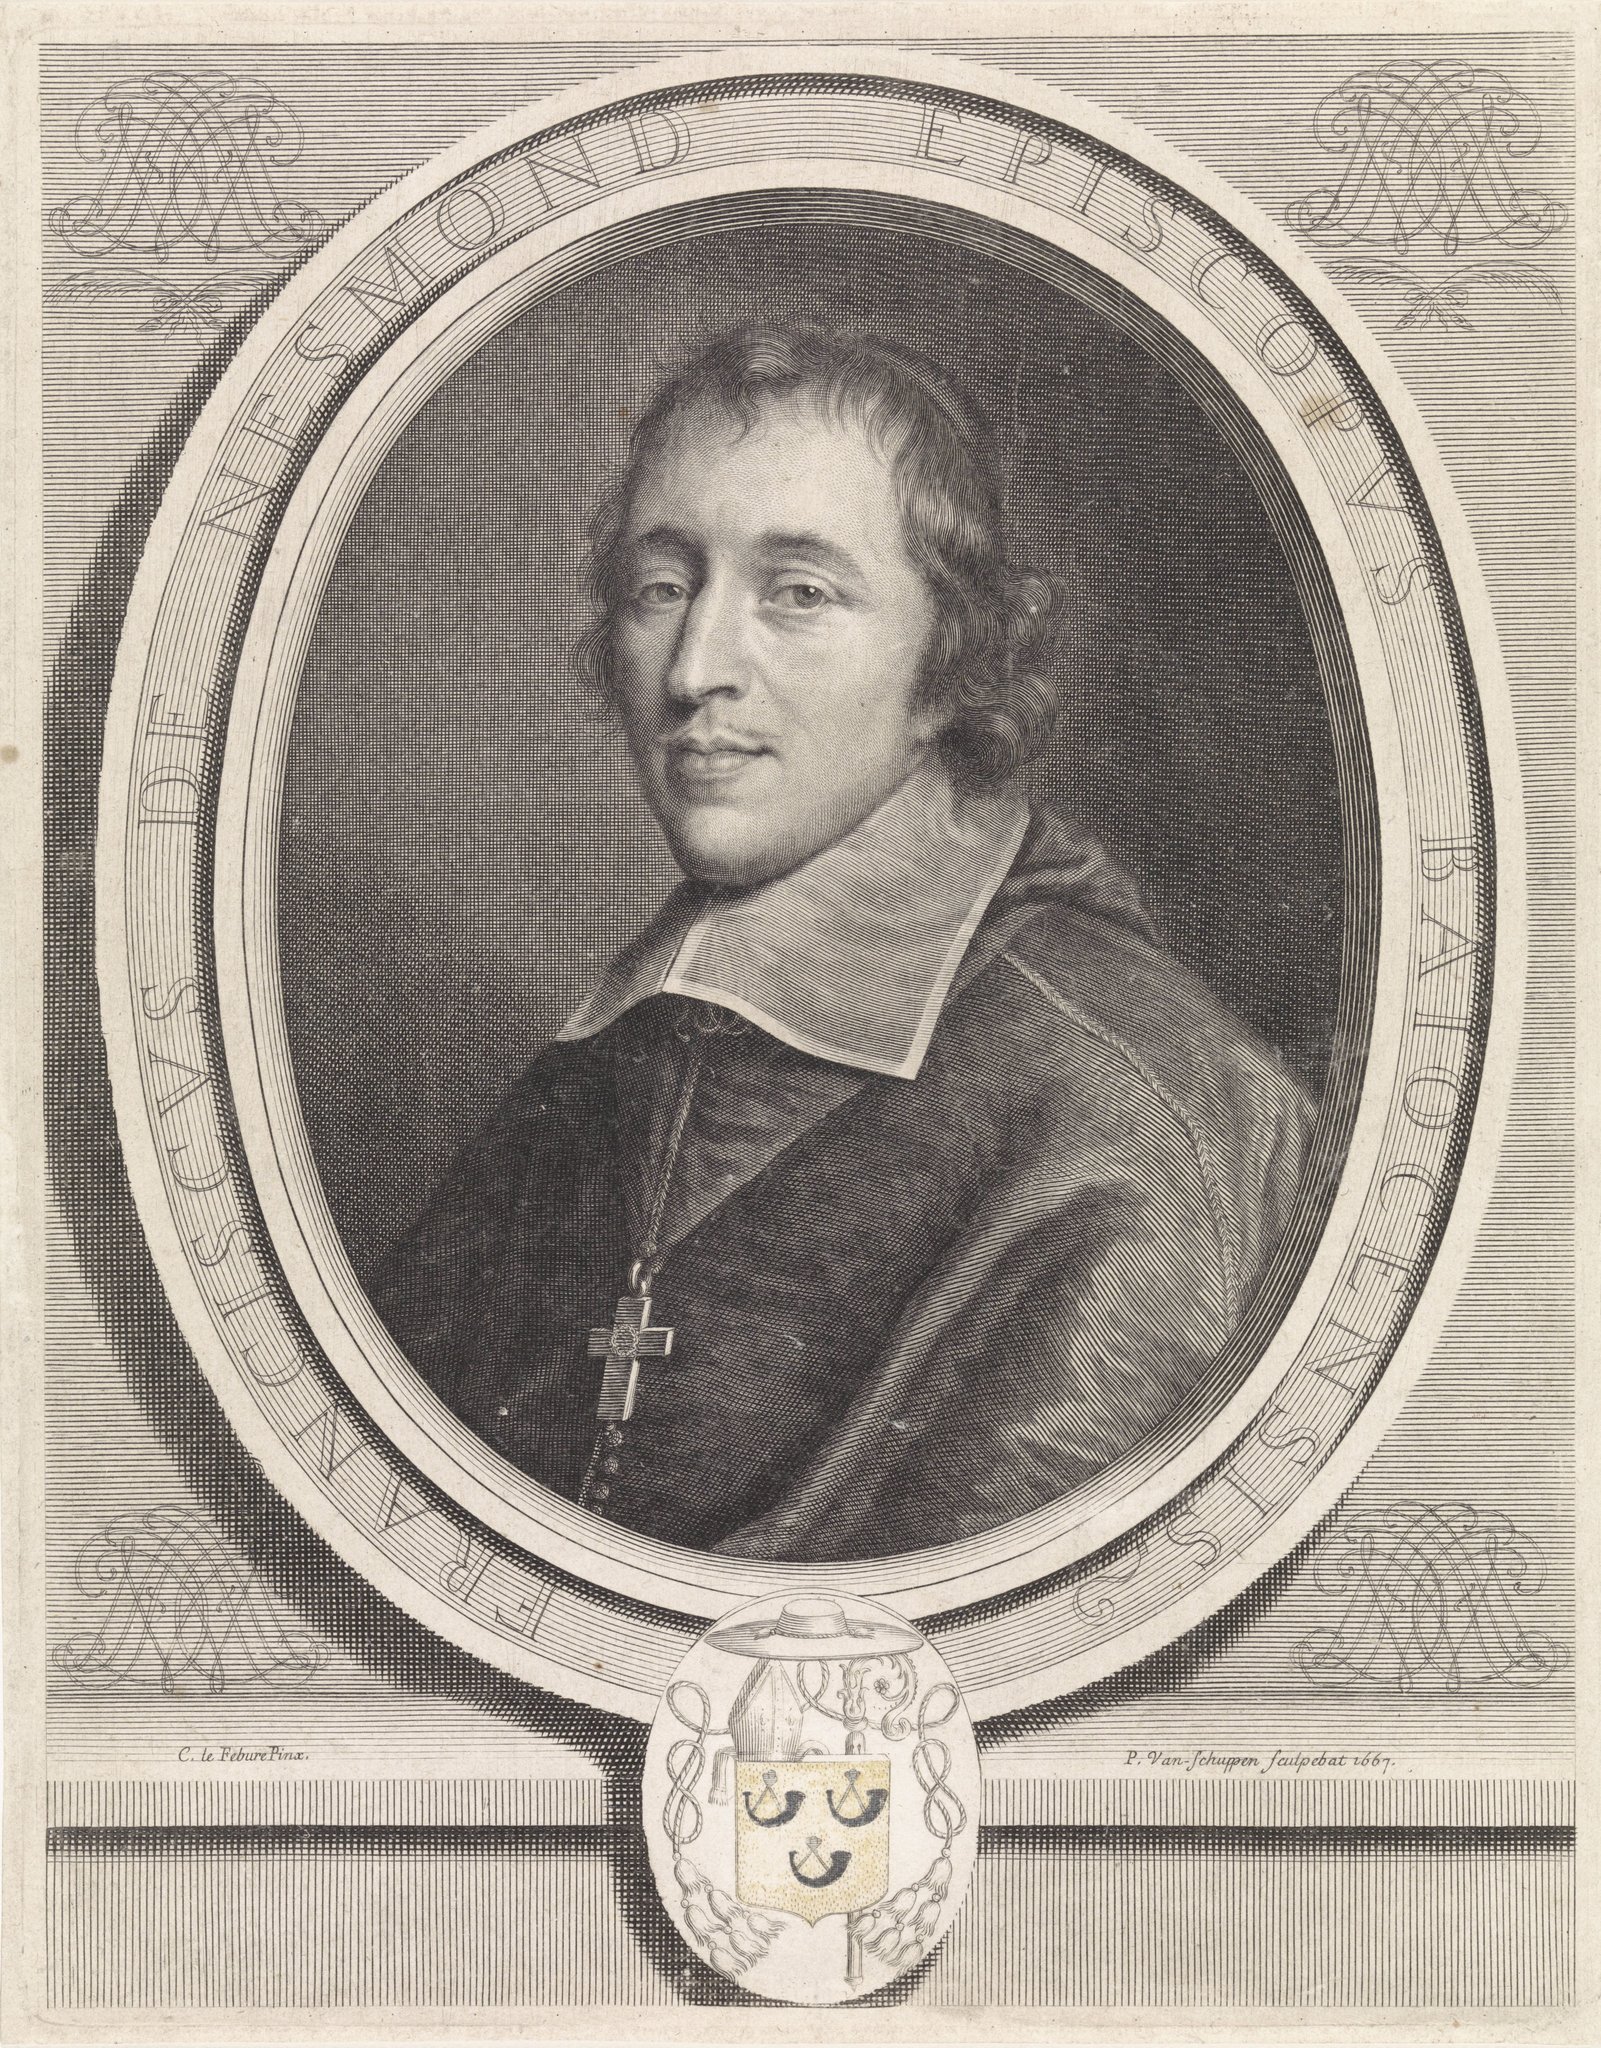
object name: print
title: Portret van François (II) de Nesmond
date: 1667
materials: paper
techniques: brush, etching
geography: paris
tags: clergyman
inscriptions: collector's mark: Lugt 2228, number: ‘11461’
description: Portret van François (II) de Nesmond, bisschop van Bayeux. In de omlijsting zijn naam en functie, in de hoeken vier monogrammen en onder het portret zijn wapenschild, voorzien van mijter, bisschopsstaf en bisschopshoed met kwasten.